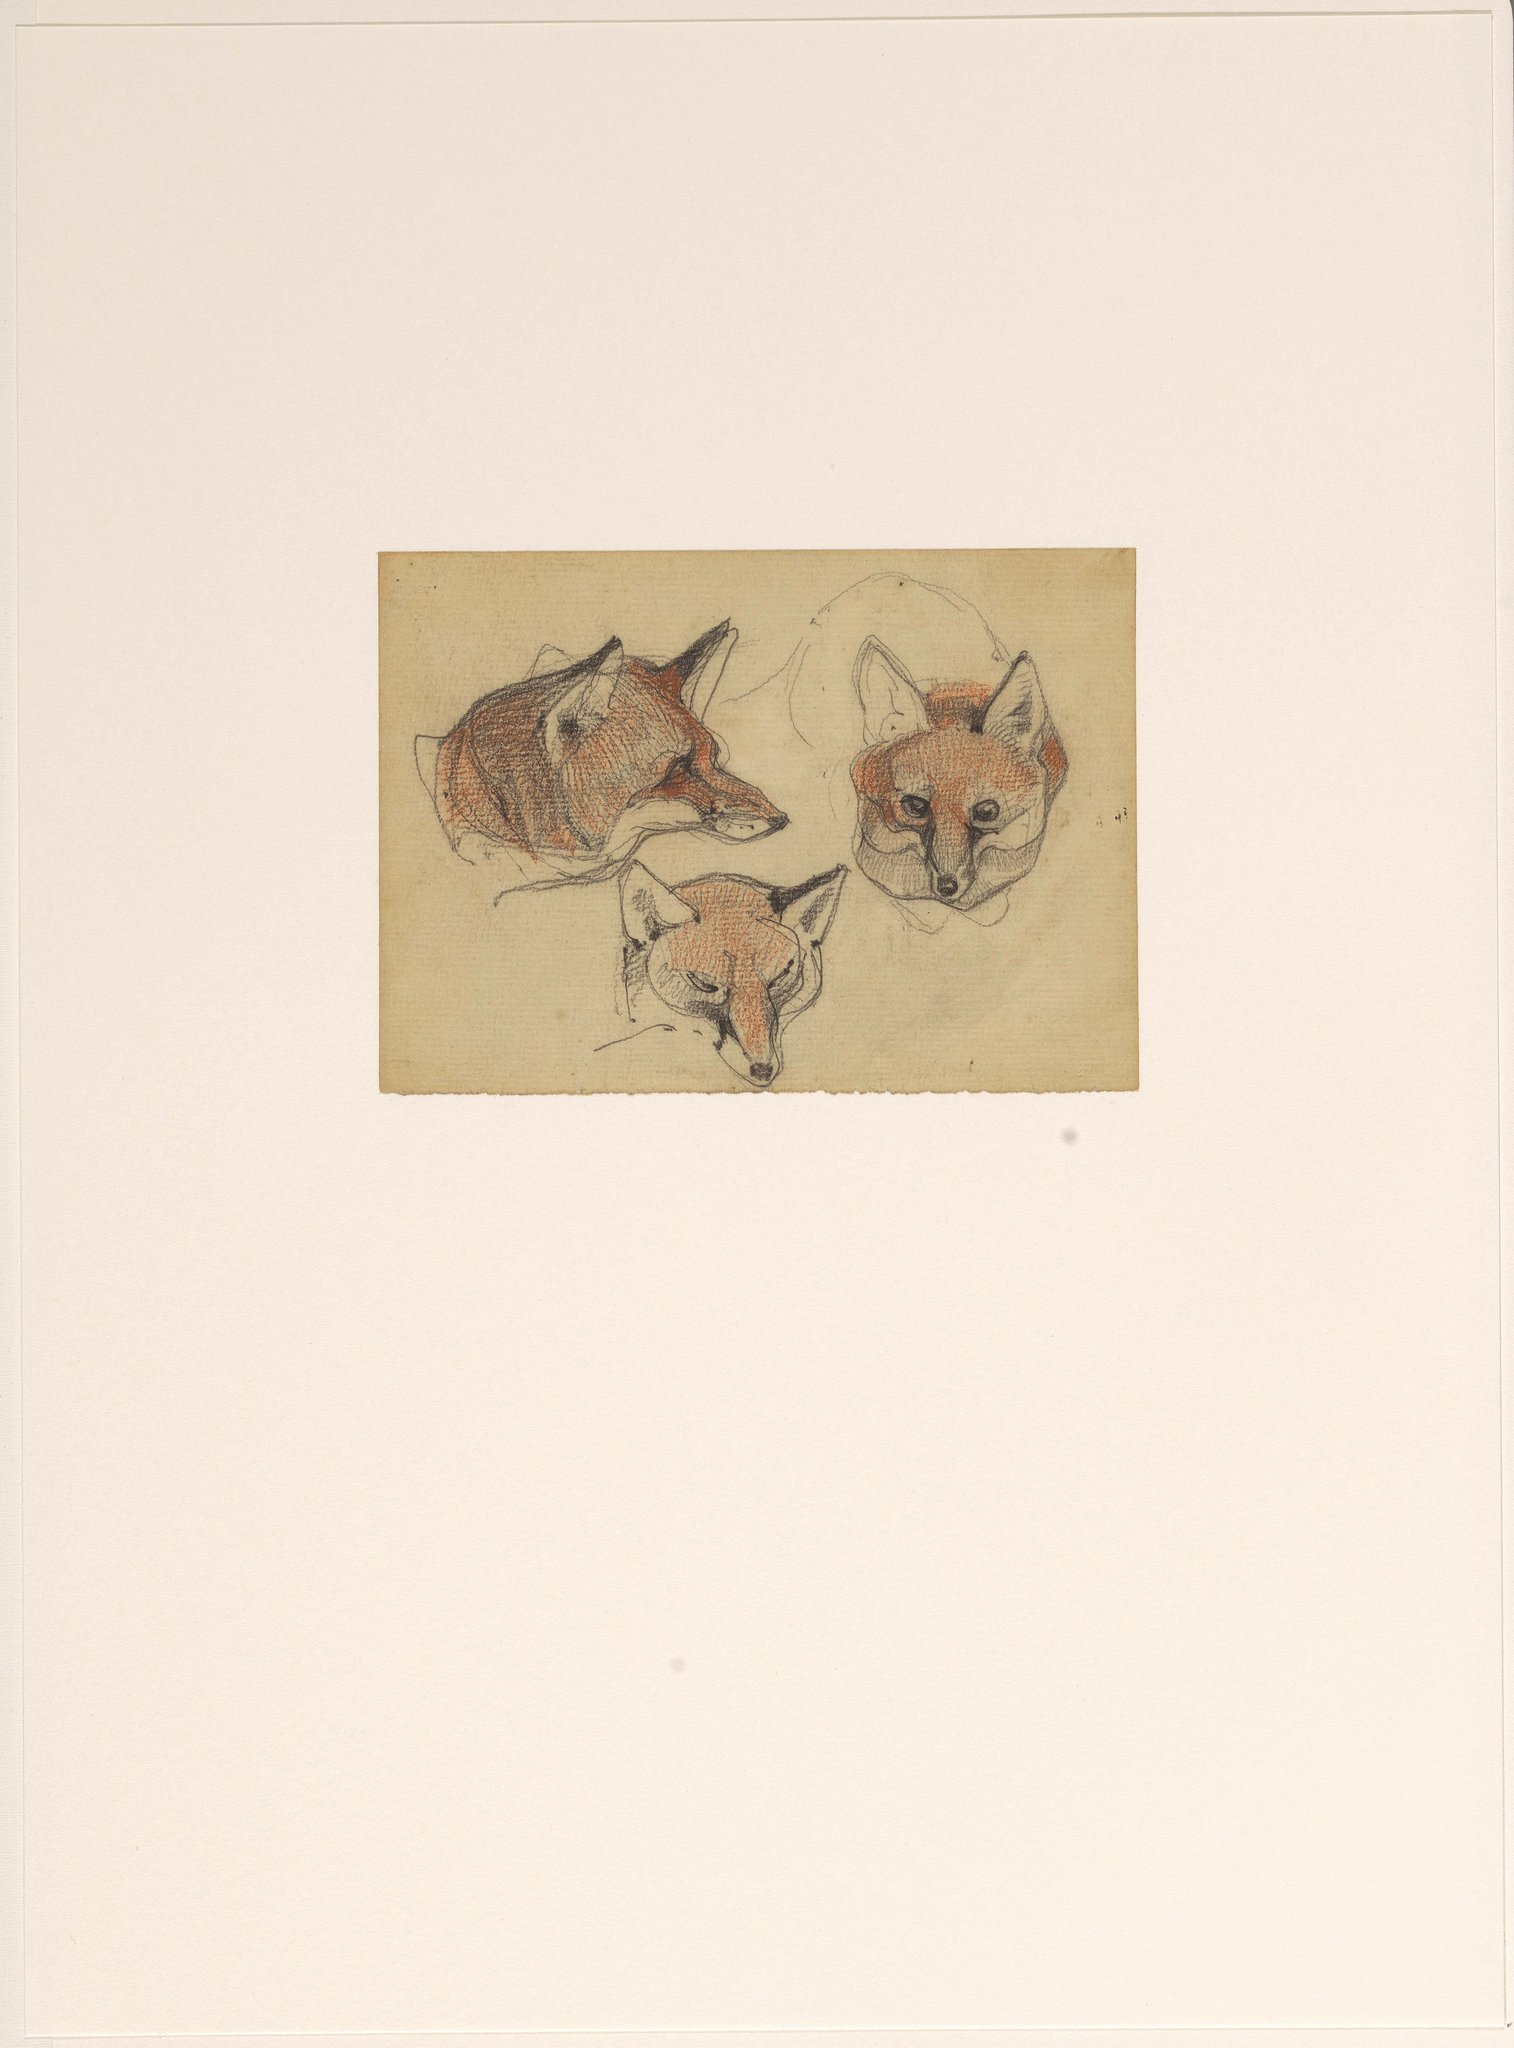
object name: drawing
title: Drie vossenkoppen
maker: bernard willem wierink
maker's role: draughtsman, print maker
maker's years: 1856-1939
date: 1866-1939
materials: chalk, paper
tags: beasts of prey, predatory animals: fox